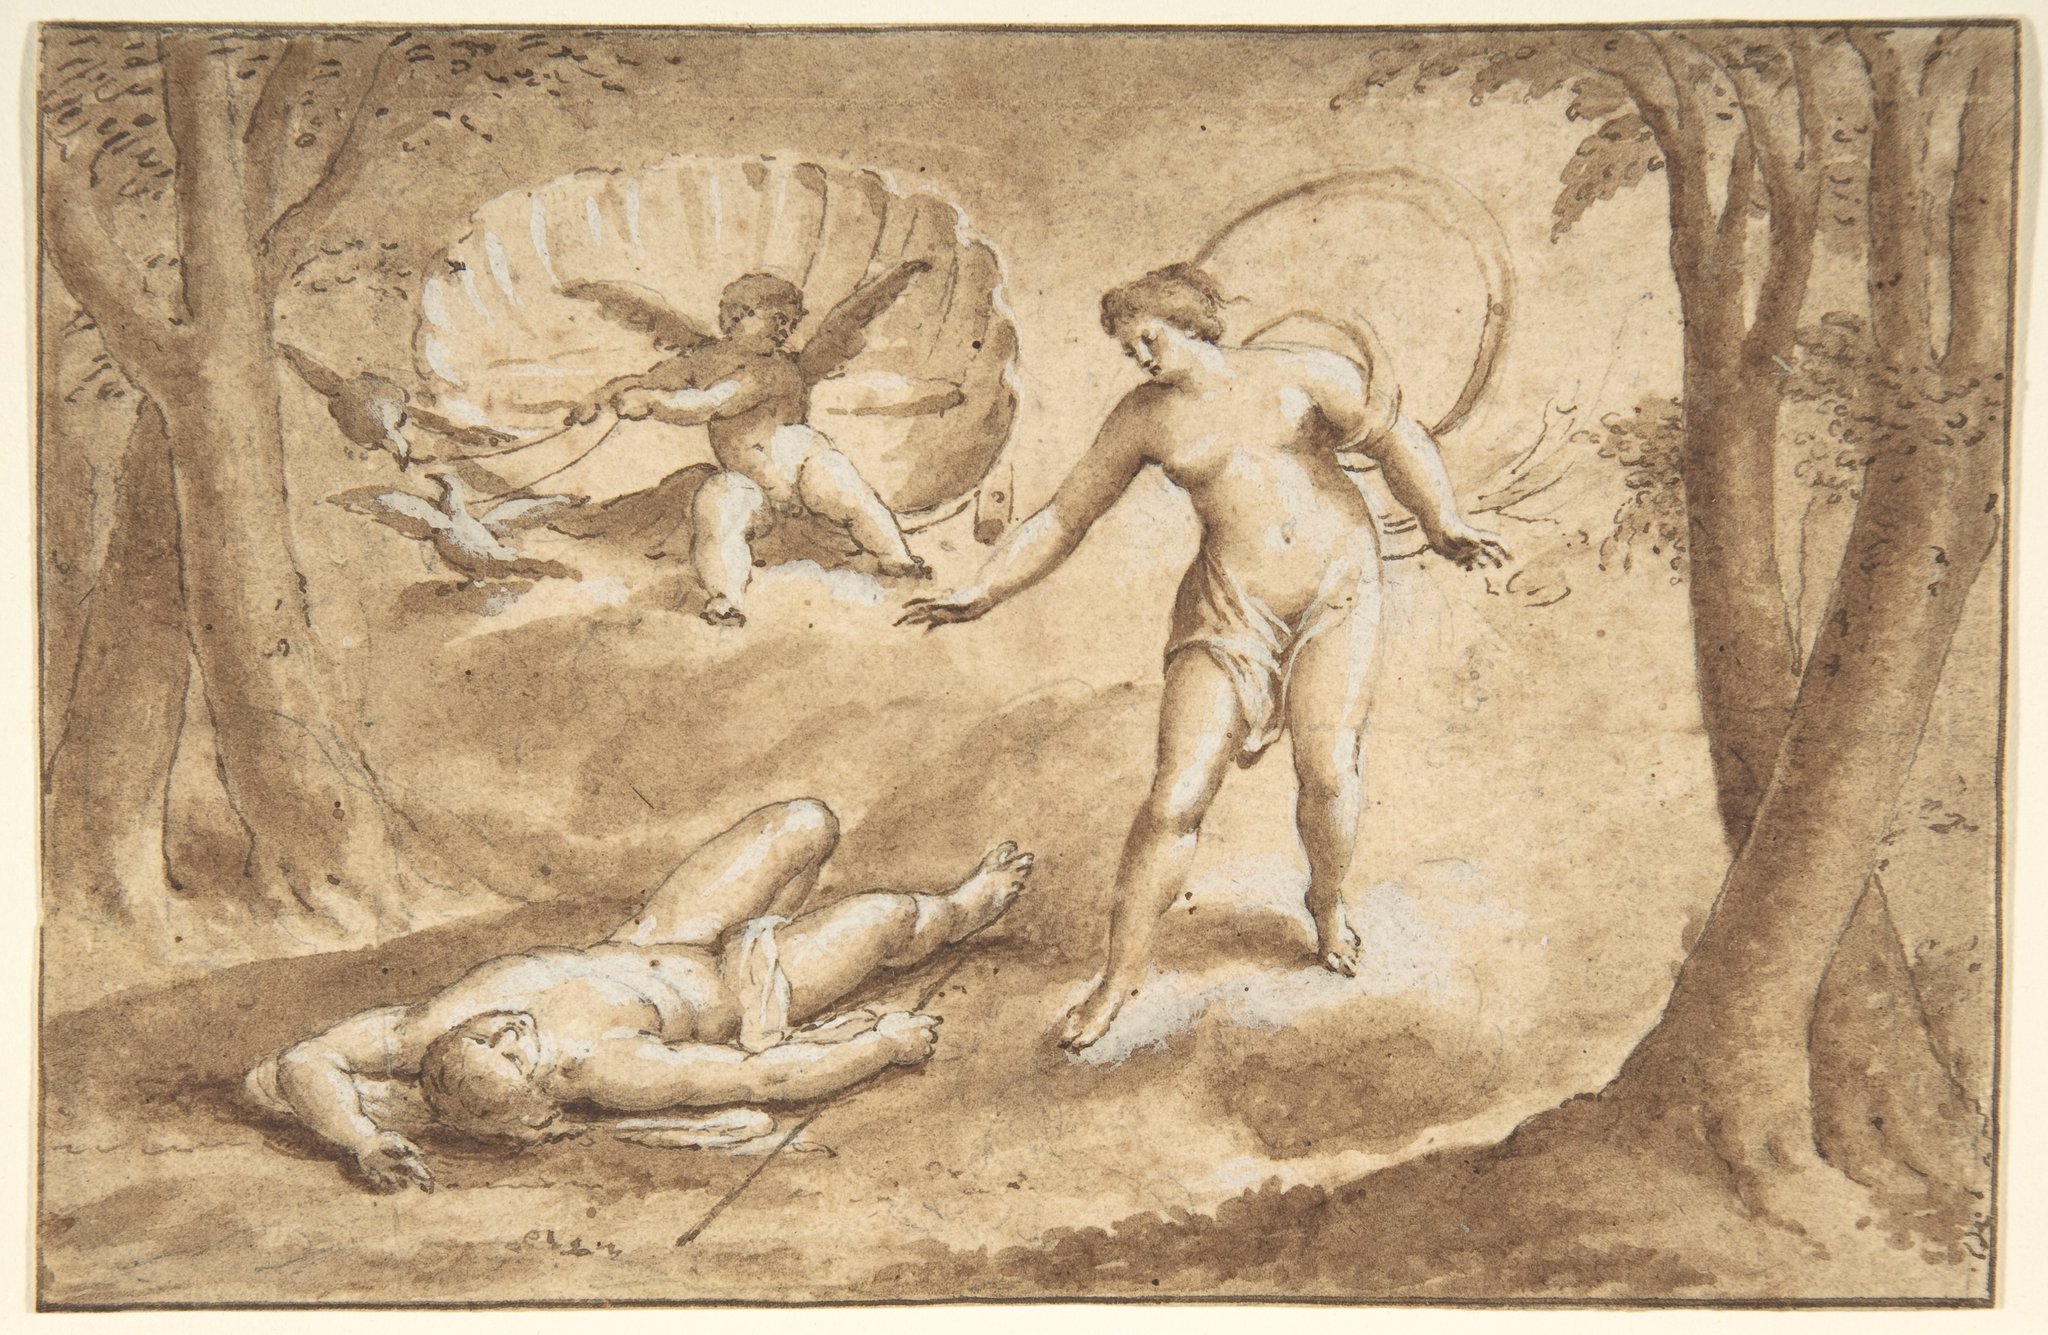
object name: drawing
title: Venus Discovering the Death of Adonis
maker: anonymous, dutch, 17th century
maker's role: artist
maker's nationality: dutch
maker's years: 1600-1700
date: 1601-1700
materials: chalk, ink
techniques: brush, heightening, pen, wash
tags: birds,adonis,venus,death